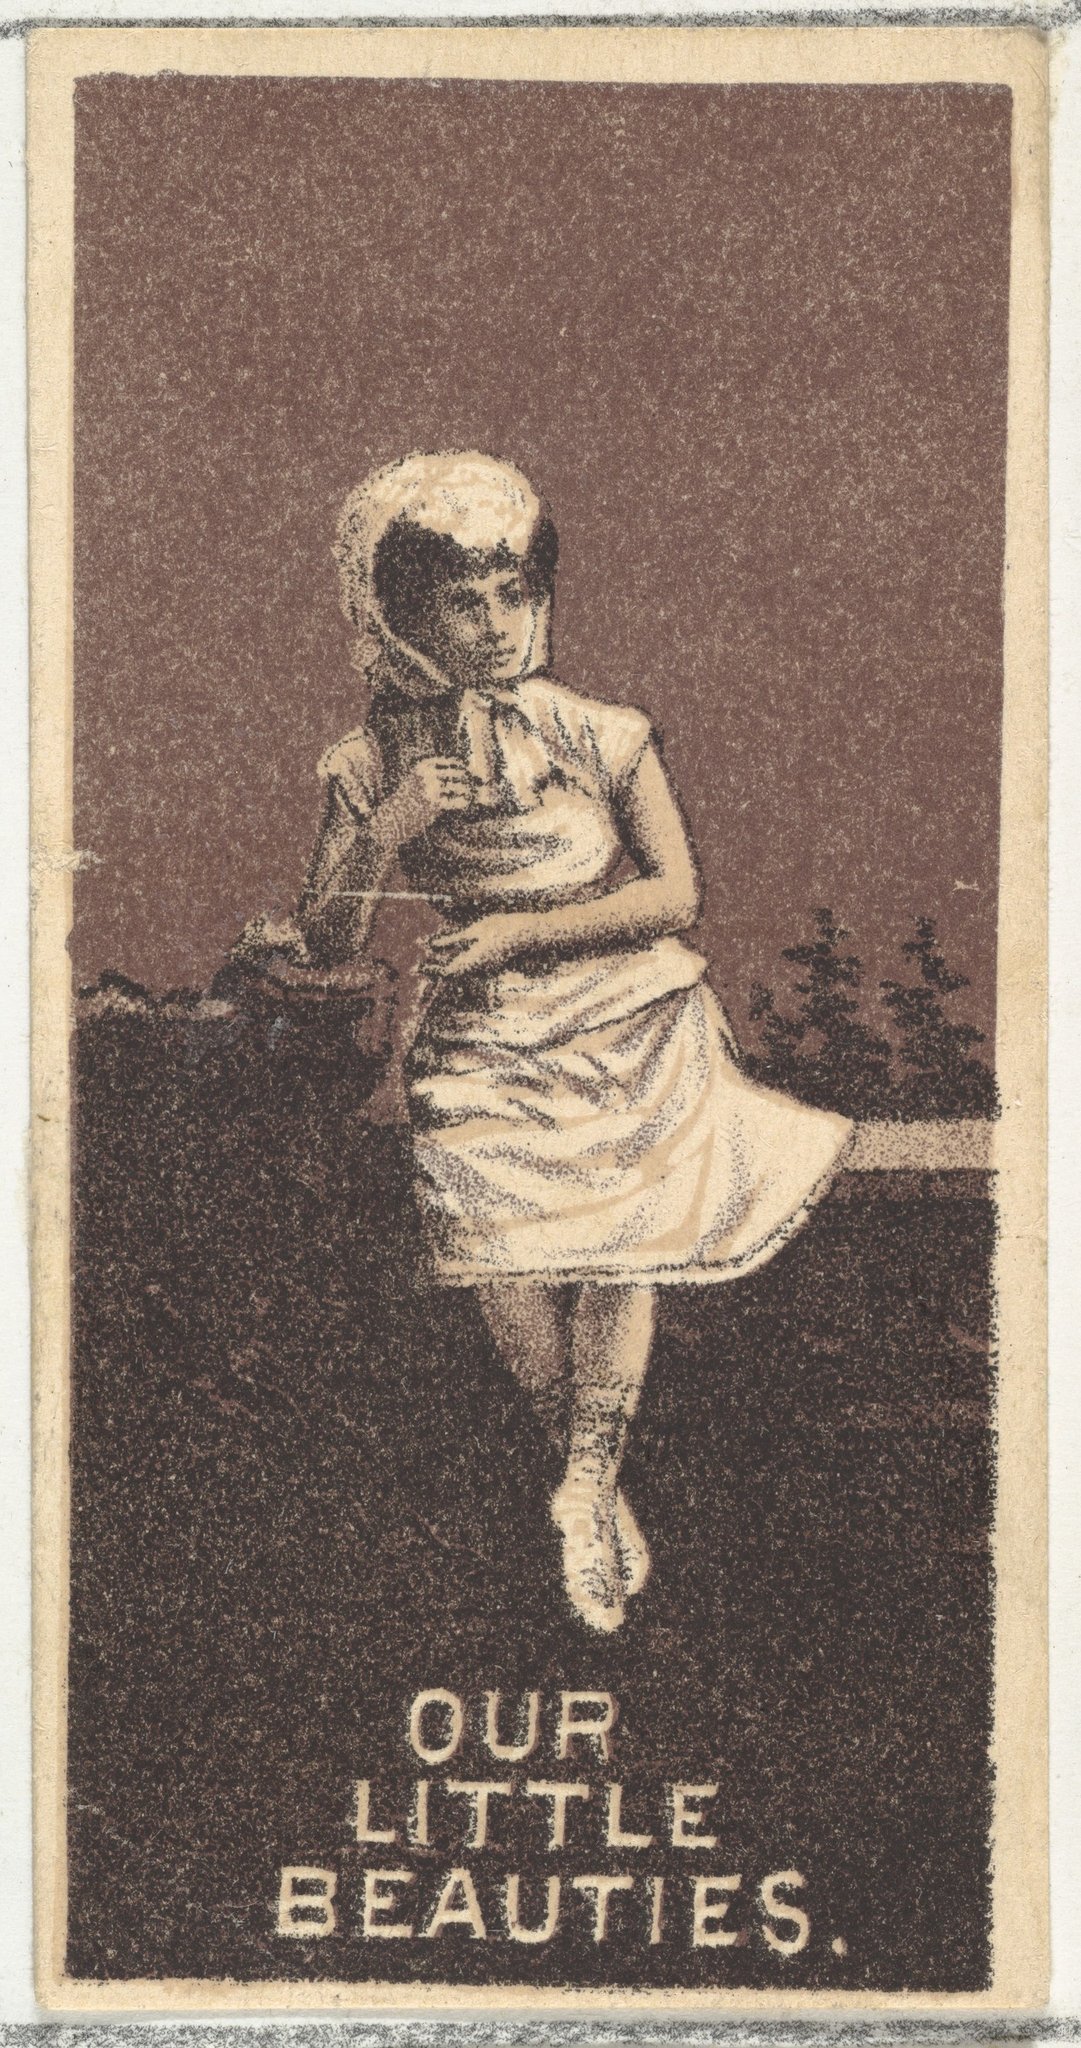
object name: print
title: From the Actresses series (N57) promoting Our Little Beauties Cigarettes for Allen & Ginter brand tobacco products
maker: allen & ginter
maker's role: publisher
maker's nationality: american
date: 1890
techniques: photolithograph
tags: portraits,women,actresses